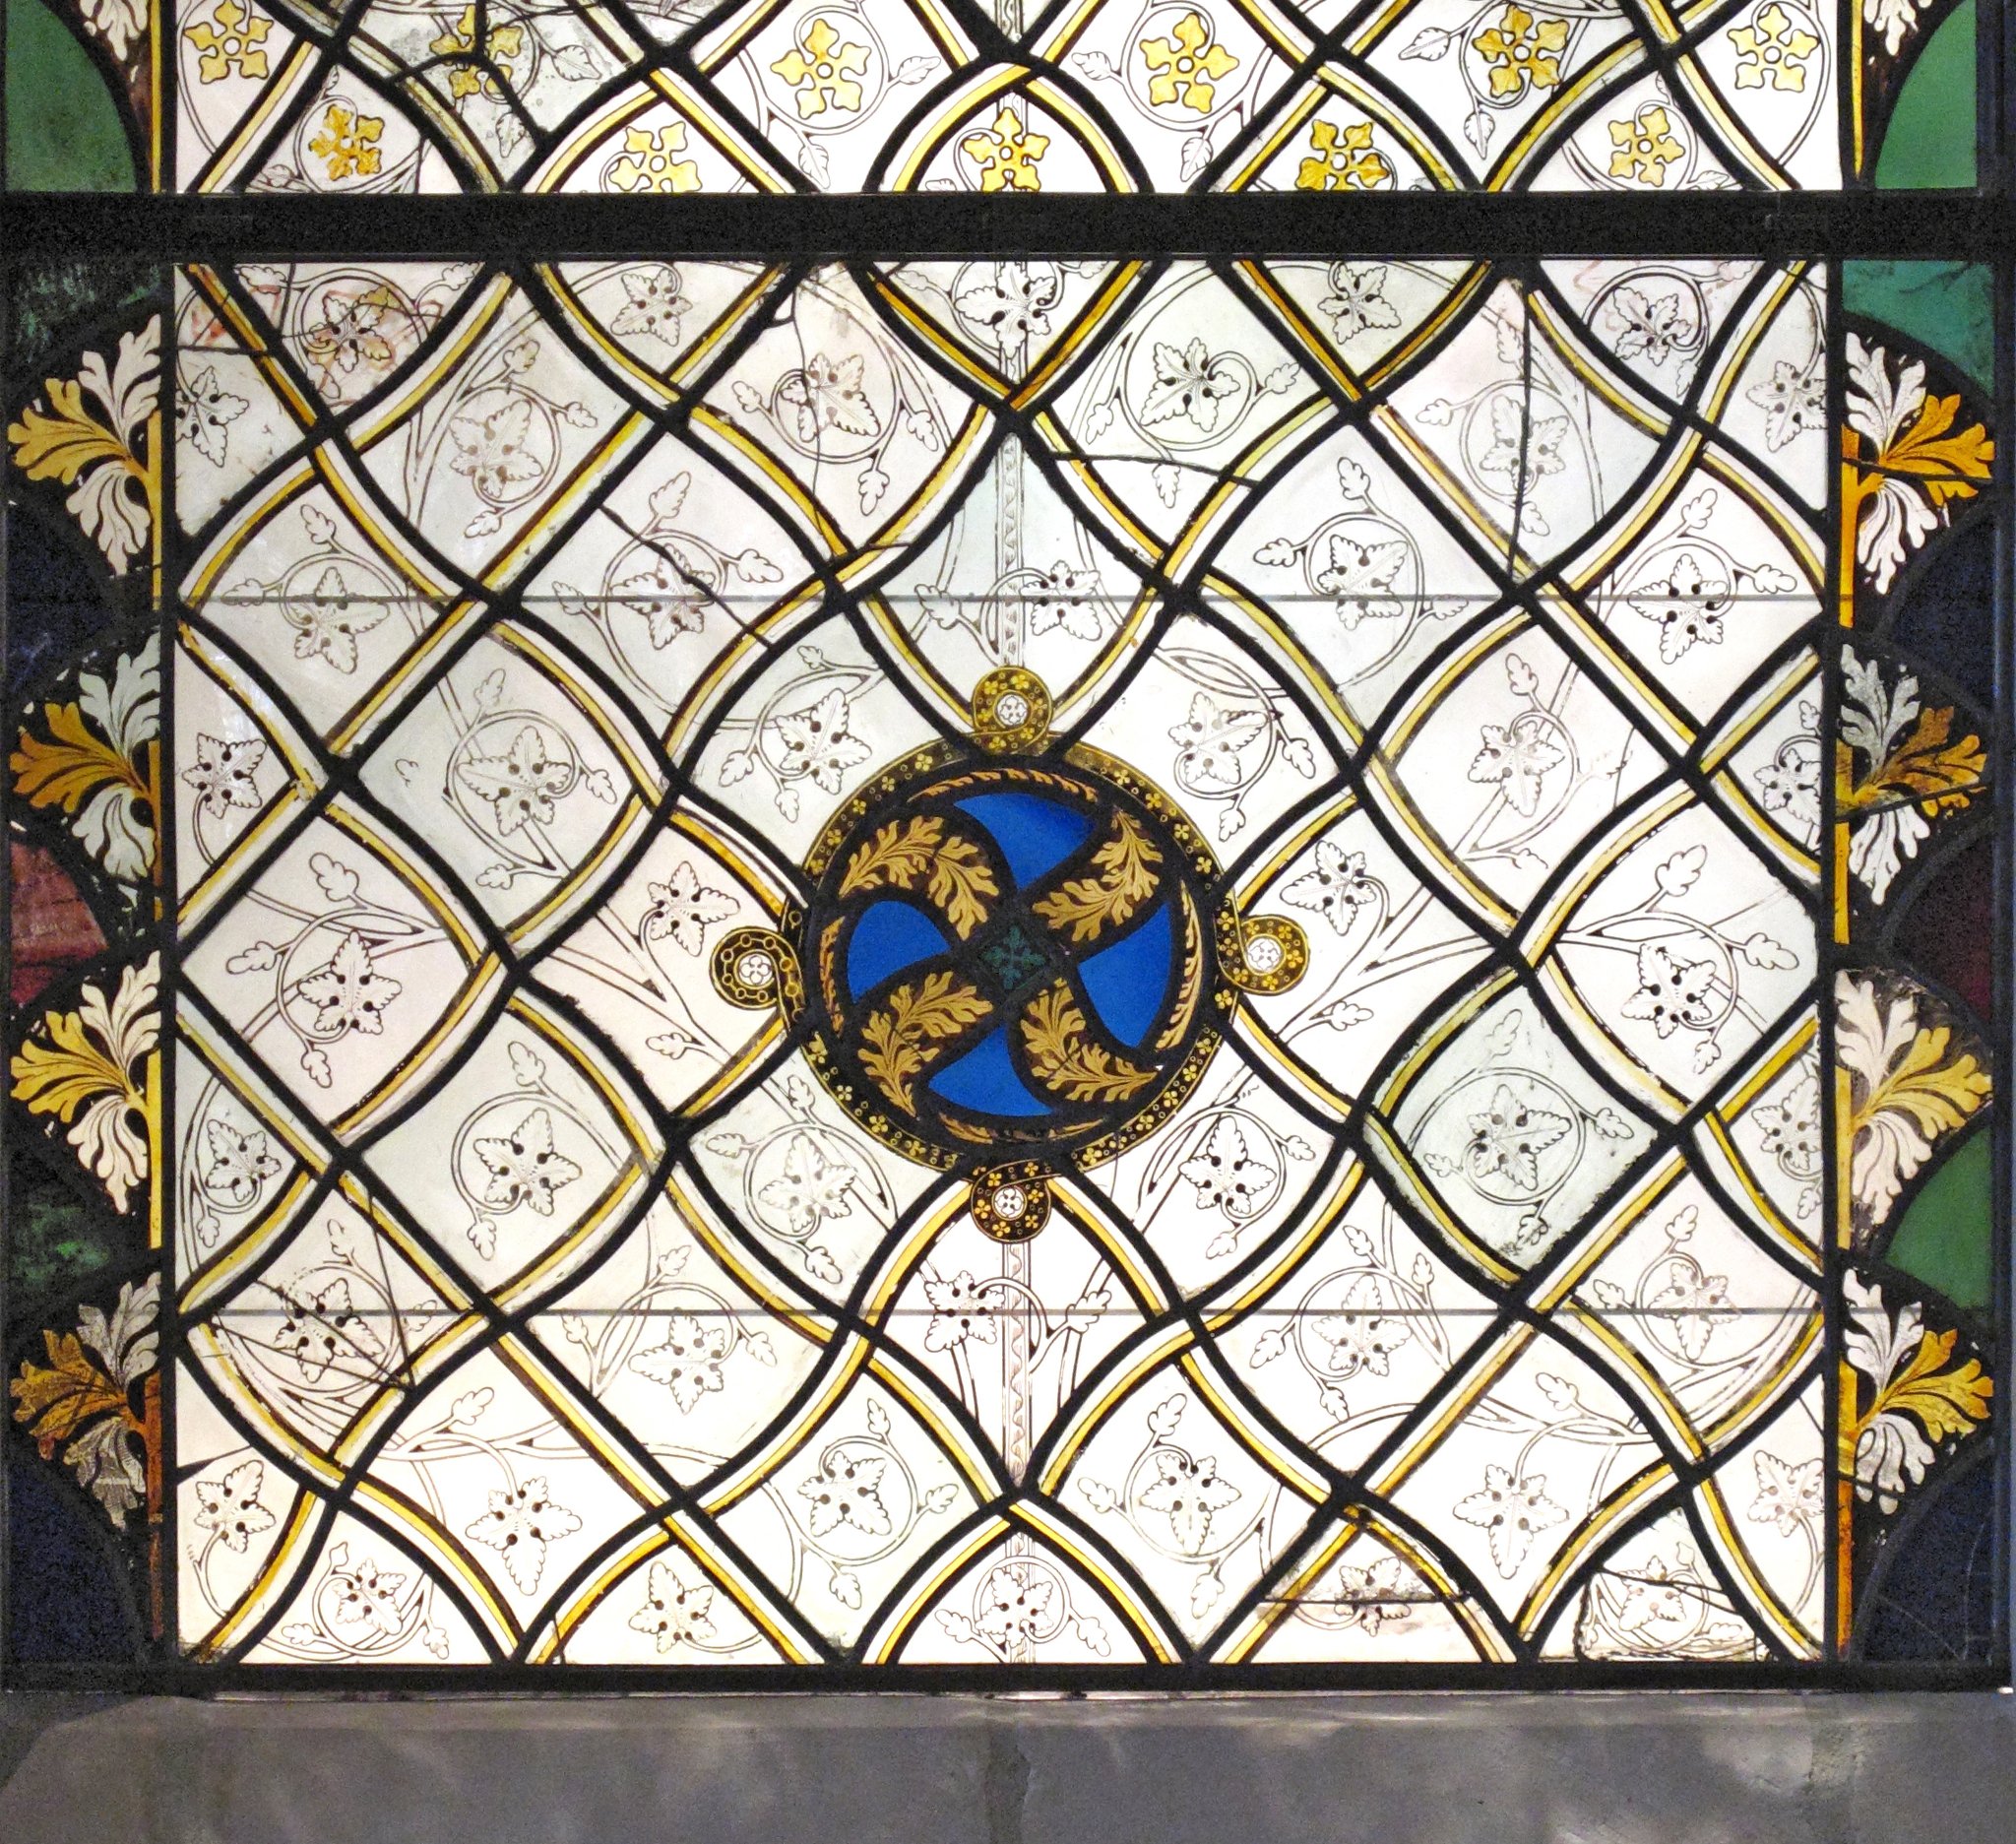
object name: panel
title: Grisaille Panel with Foliate Pattern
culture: french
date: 1320-1330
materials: glass, metal, paint, pigment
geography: france